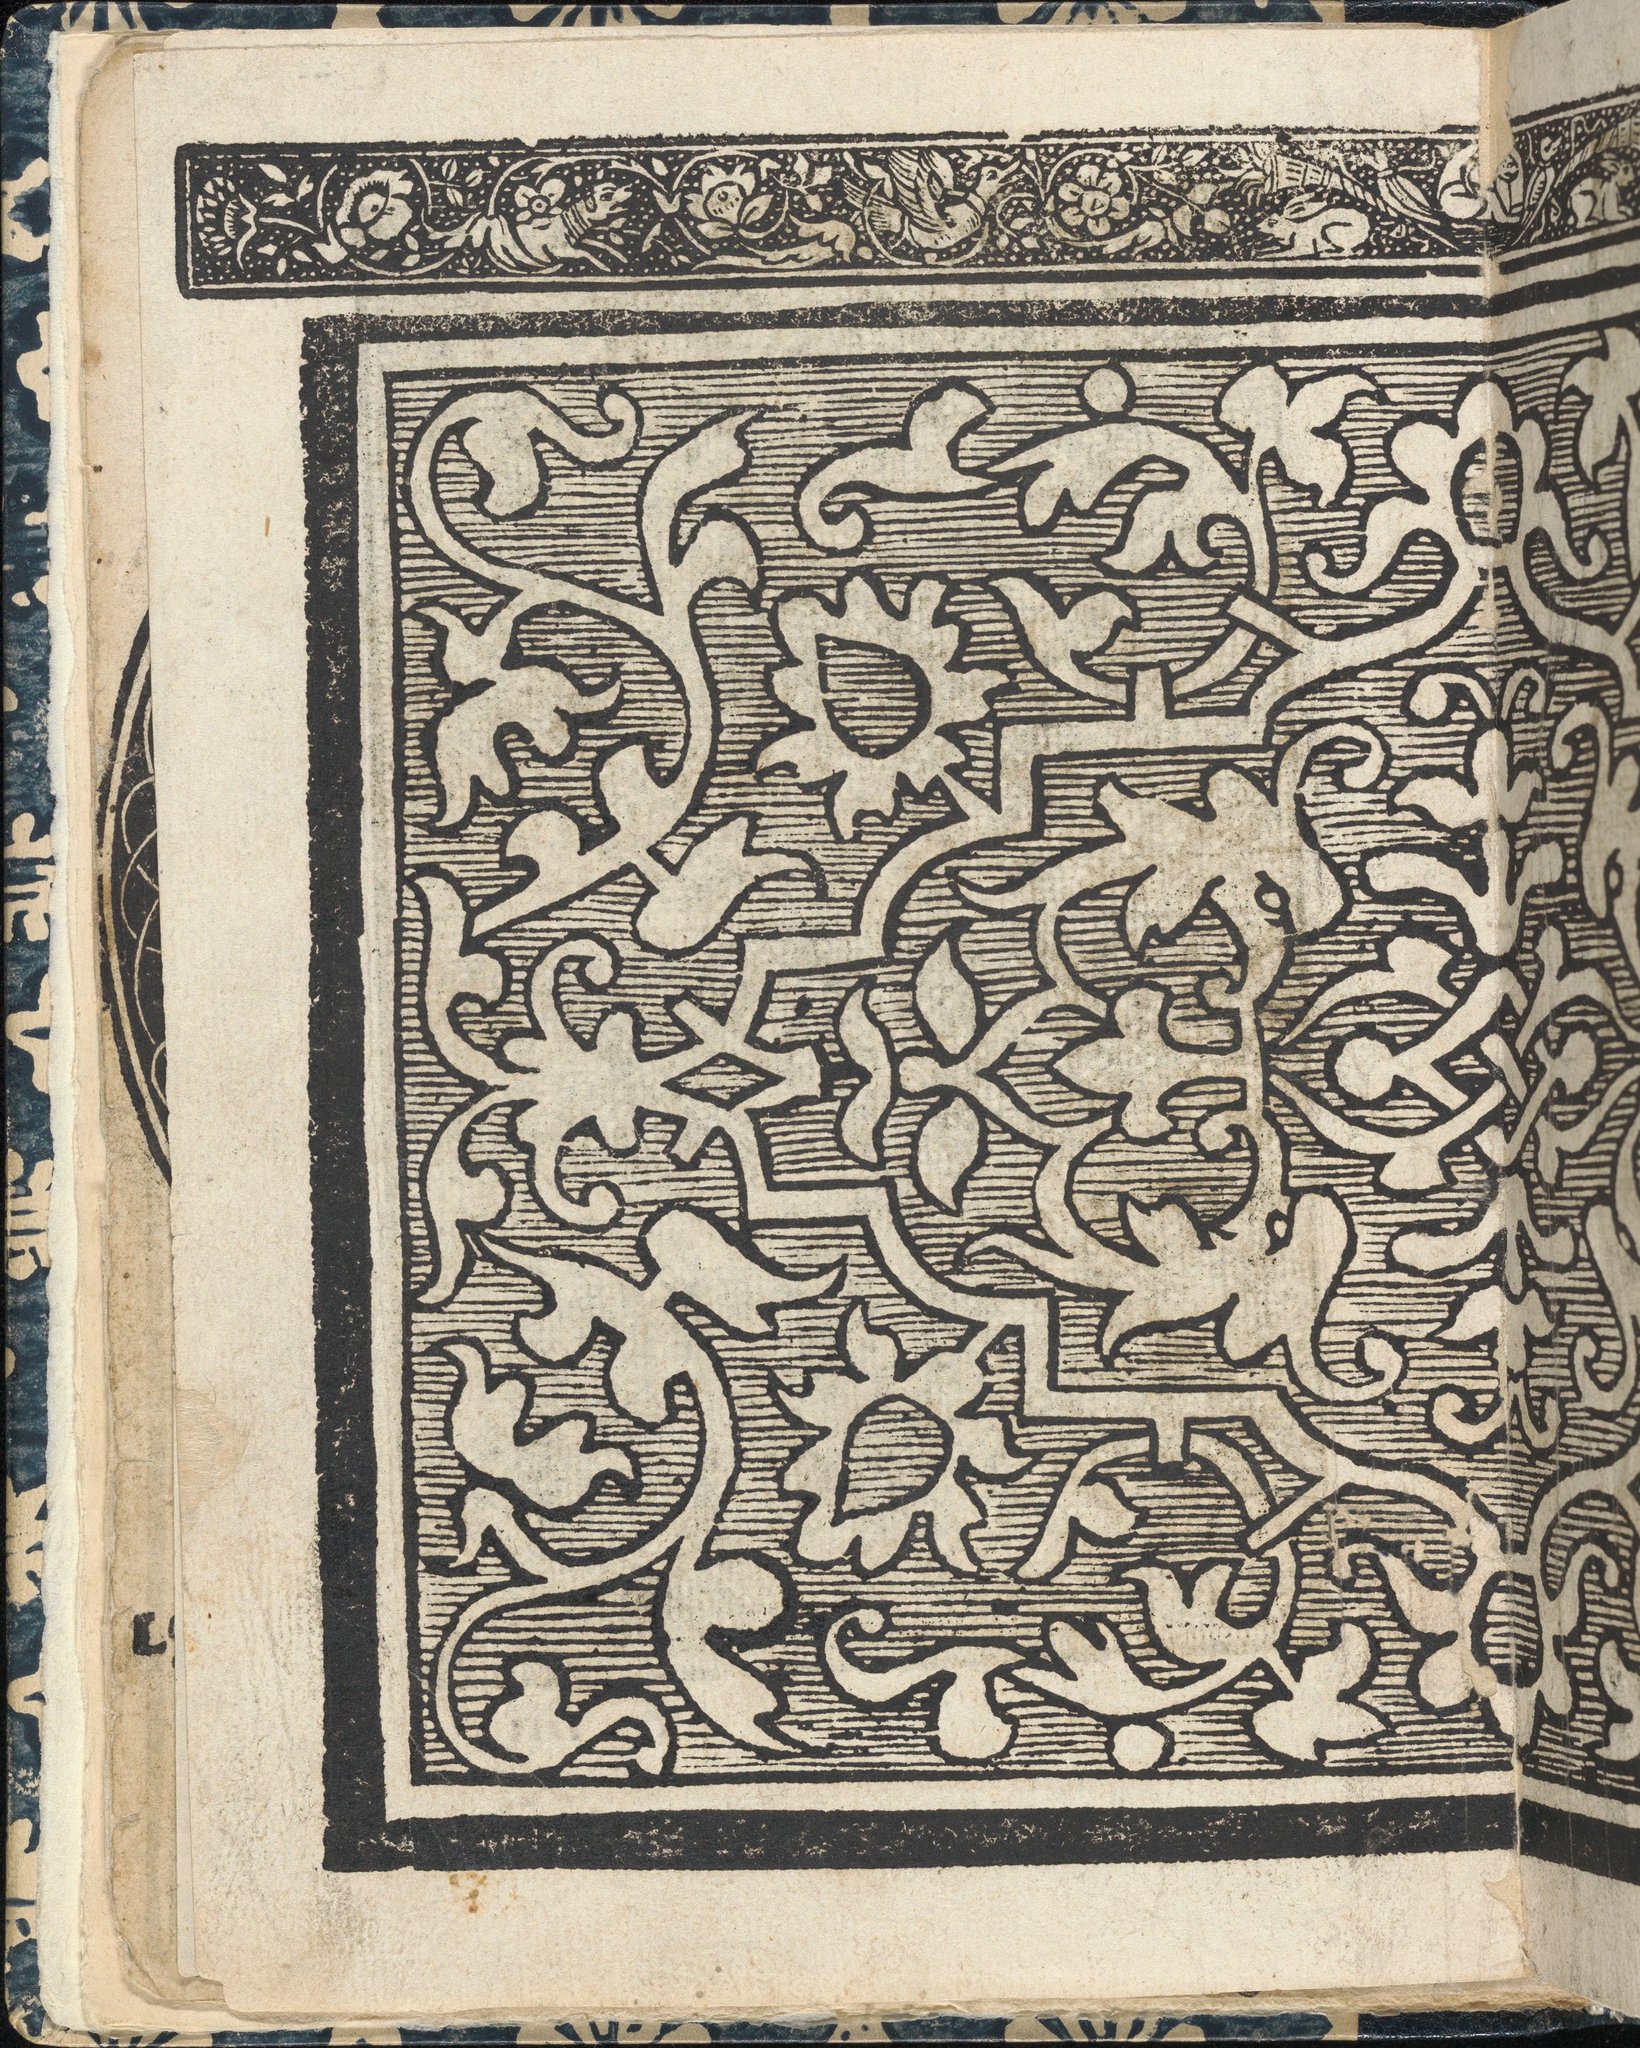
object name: book print ornament architecture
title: Essempio di recammi, page 6 (verso)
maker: giovanni antonio tagliente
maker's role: author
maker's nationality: italian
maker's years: 1465-1528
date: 1530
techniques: woodcut